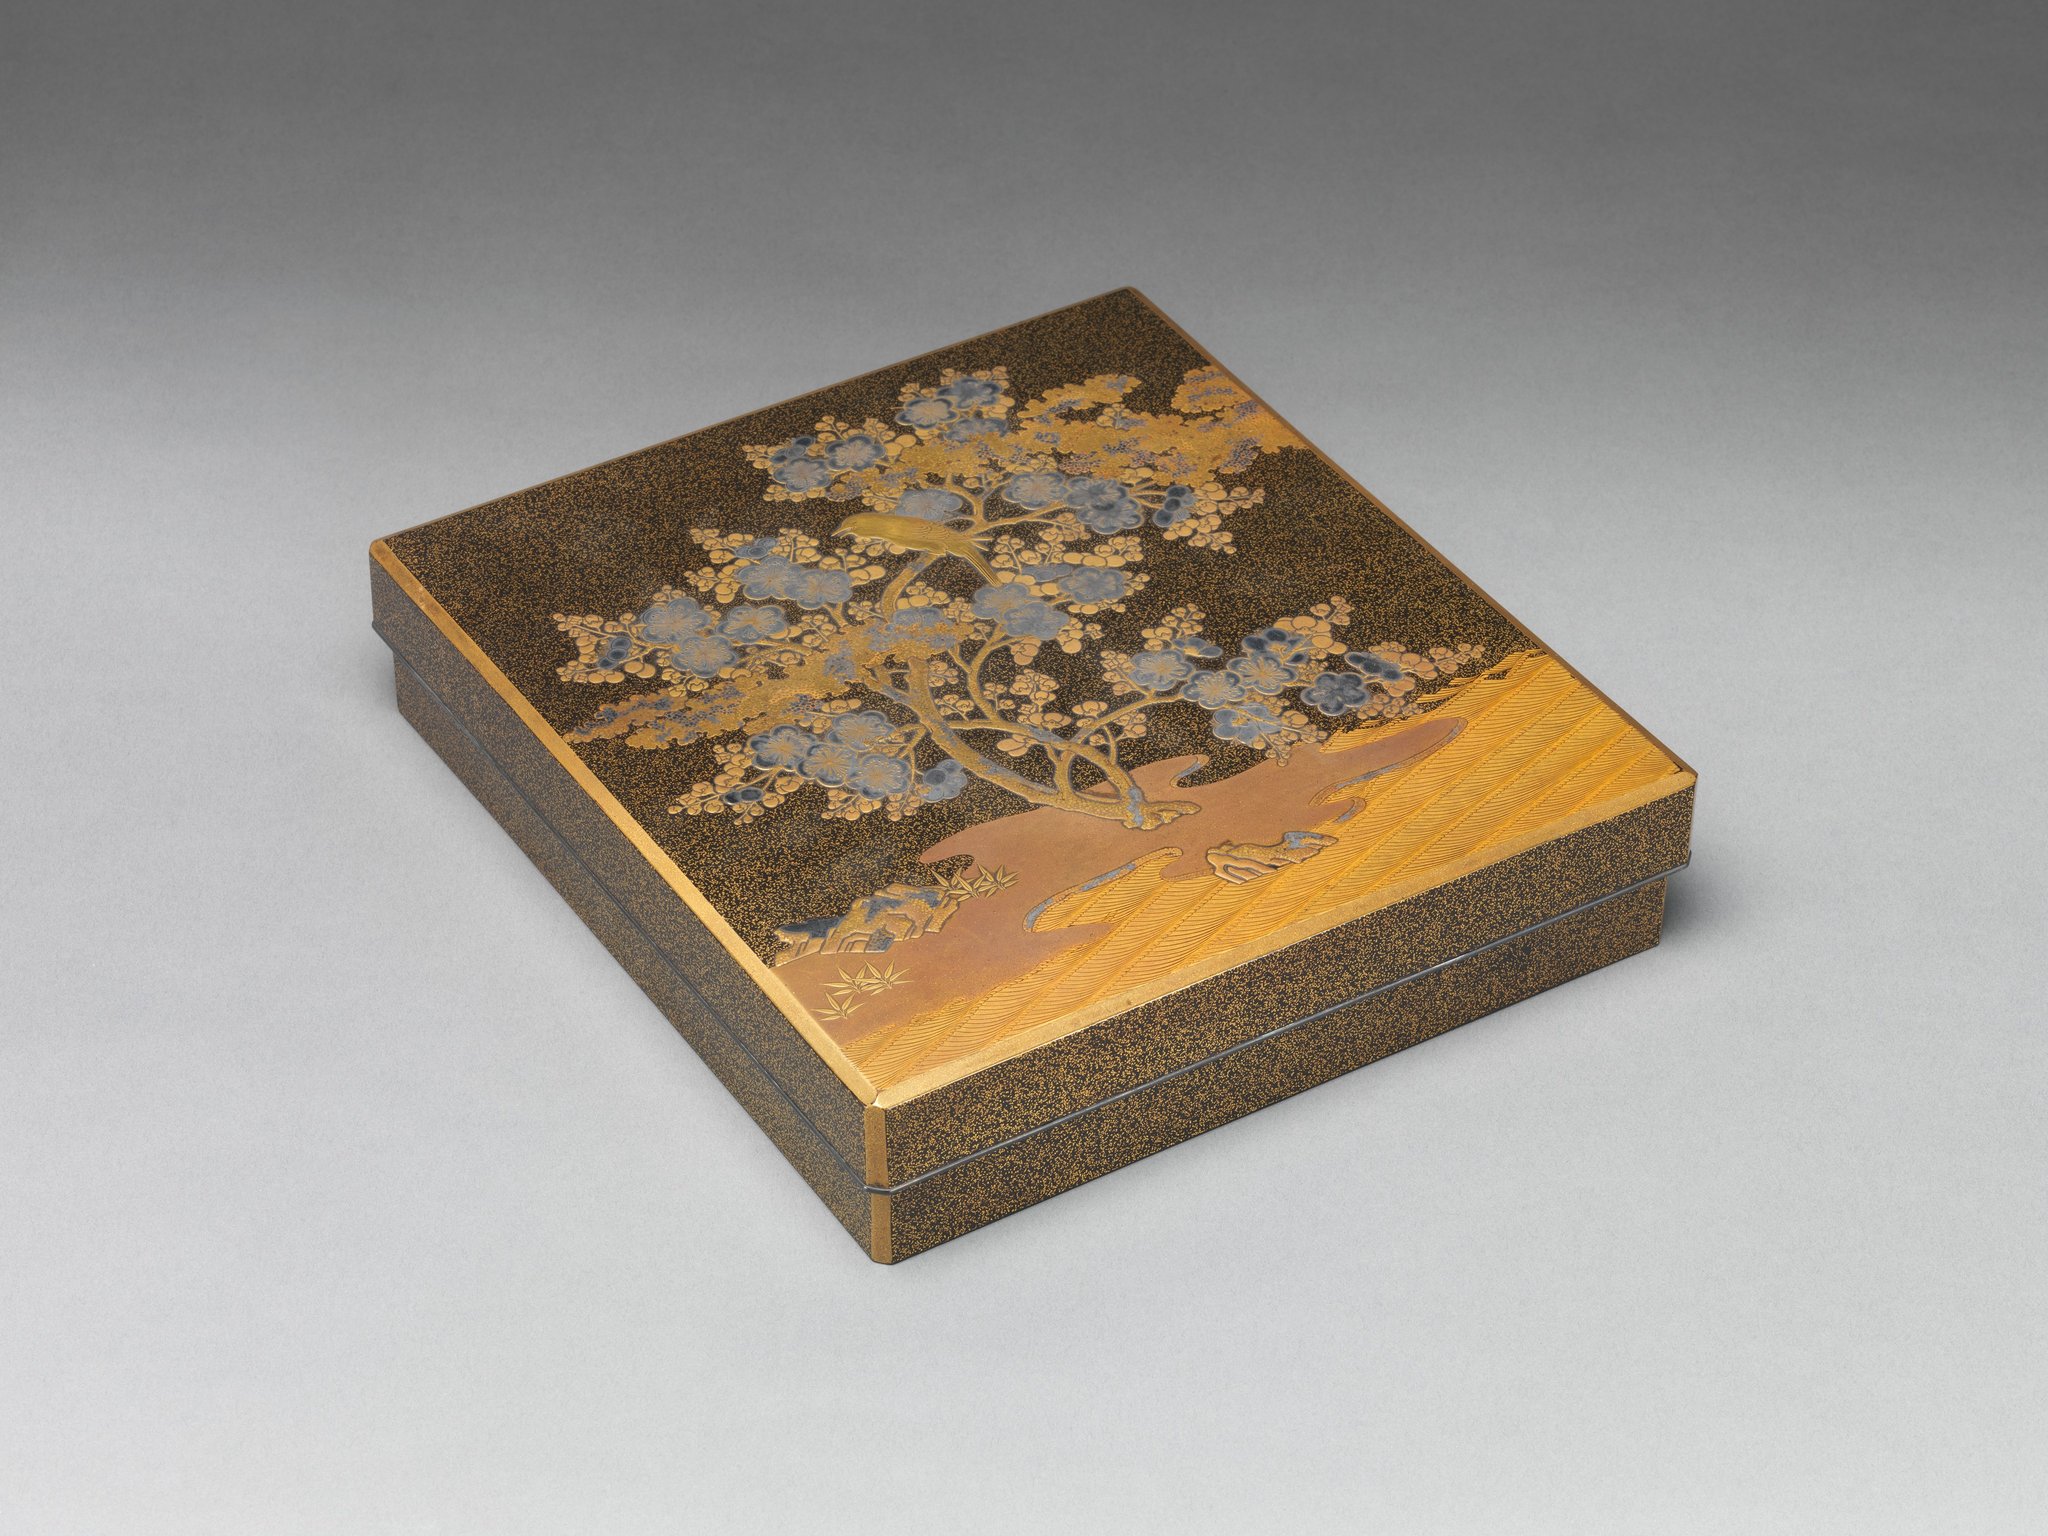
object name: writing box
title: Writing Box with Warbler in Plum Tree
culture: japanese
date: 1701-1800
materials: gold, silver, wood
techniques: hiramakie, lacquer, maki-e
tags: birds,frogs,trees